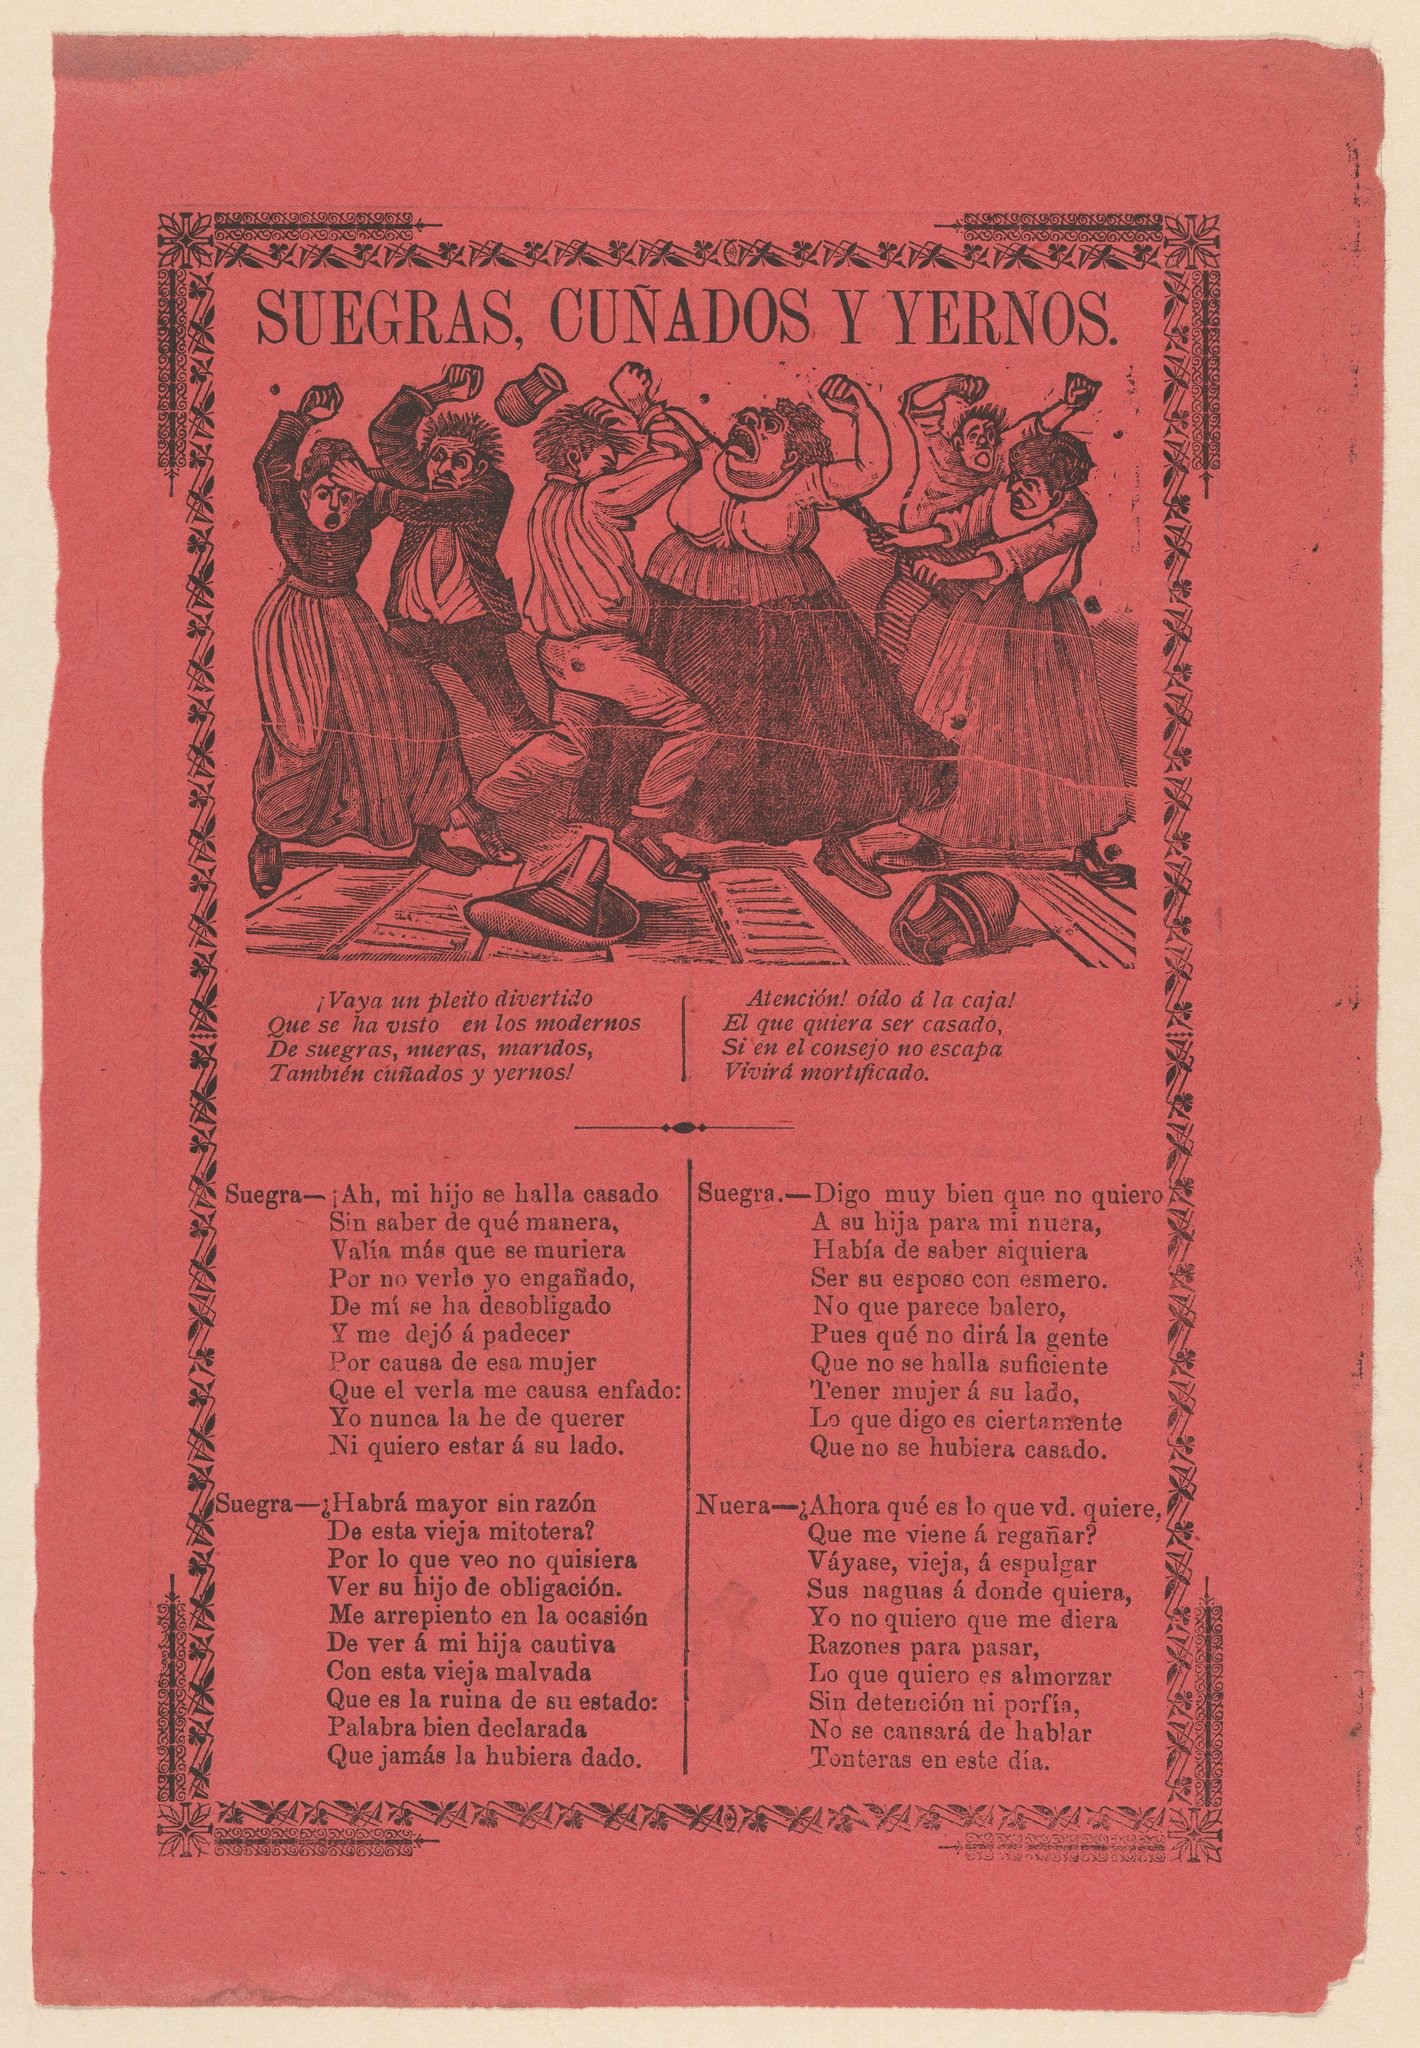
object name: print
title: Broadsheet relating to mothers-in-law, brothers-in-law and sons fighting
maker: josé guadalupe posada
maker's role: artist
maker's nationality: mexican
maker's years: 1852-1913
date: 1890-1896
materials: metal, paper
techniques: engraving, letterpress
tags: men,women